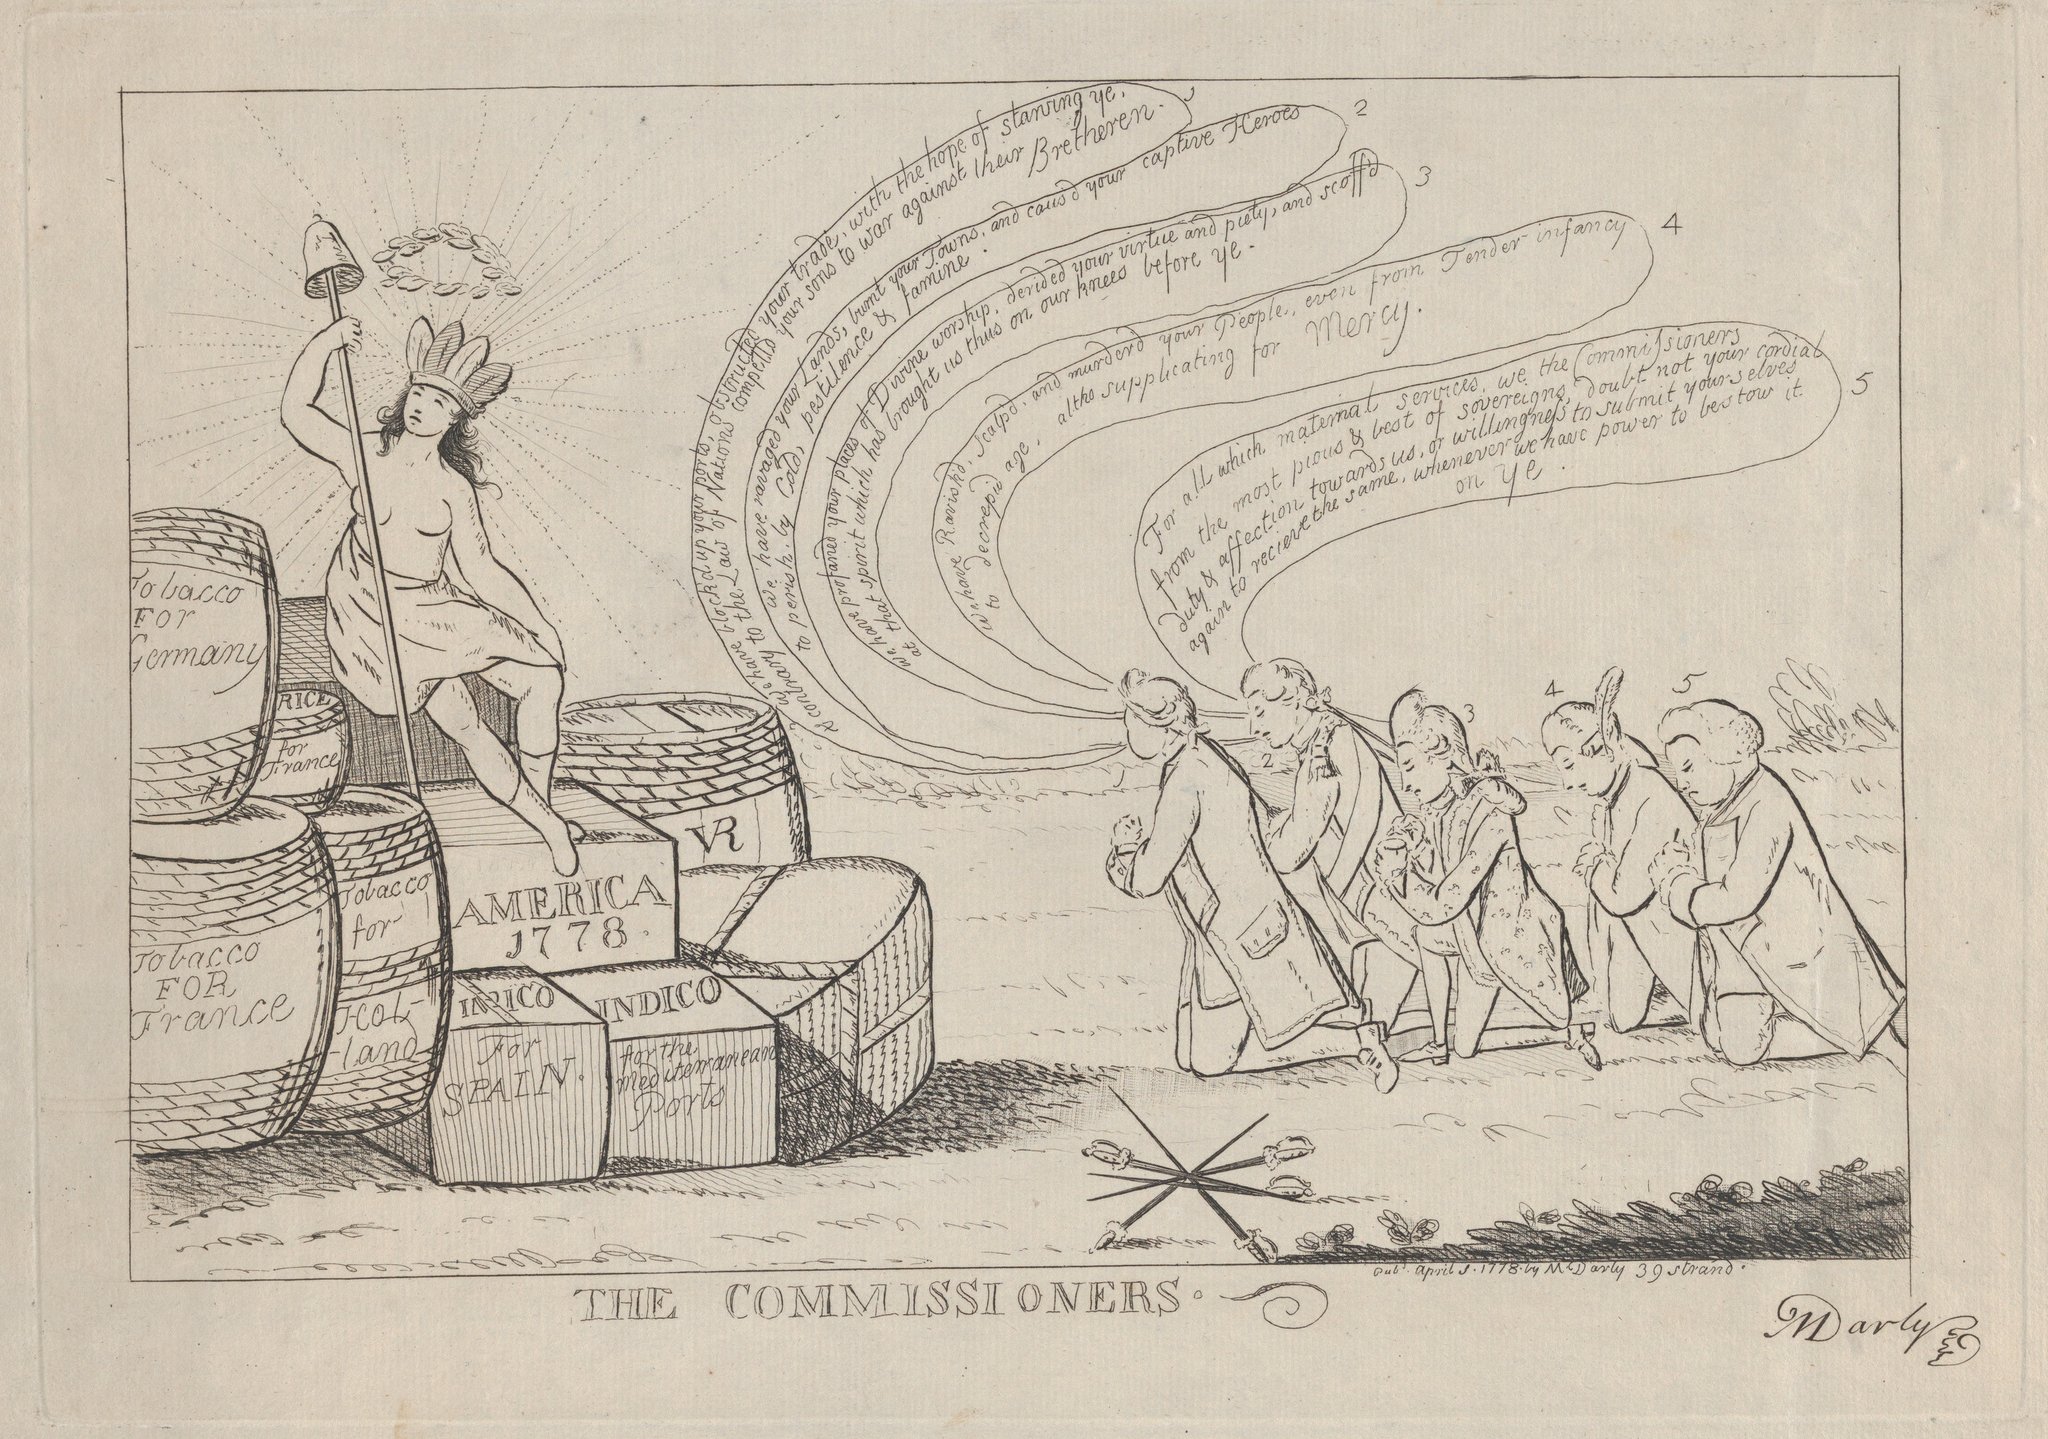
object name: print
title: The Commissioners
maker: matthias darly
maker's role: publisher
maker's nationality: british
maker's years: 1720-1780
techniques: etching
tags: satire,american revolution,men,politics